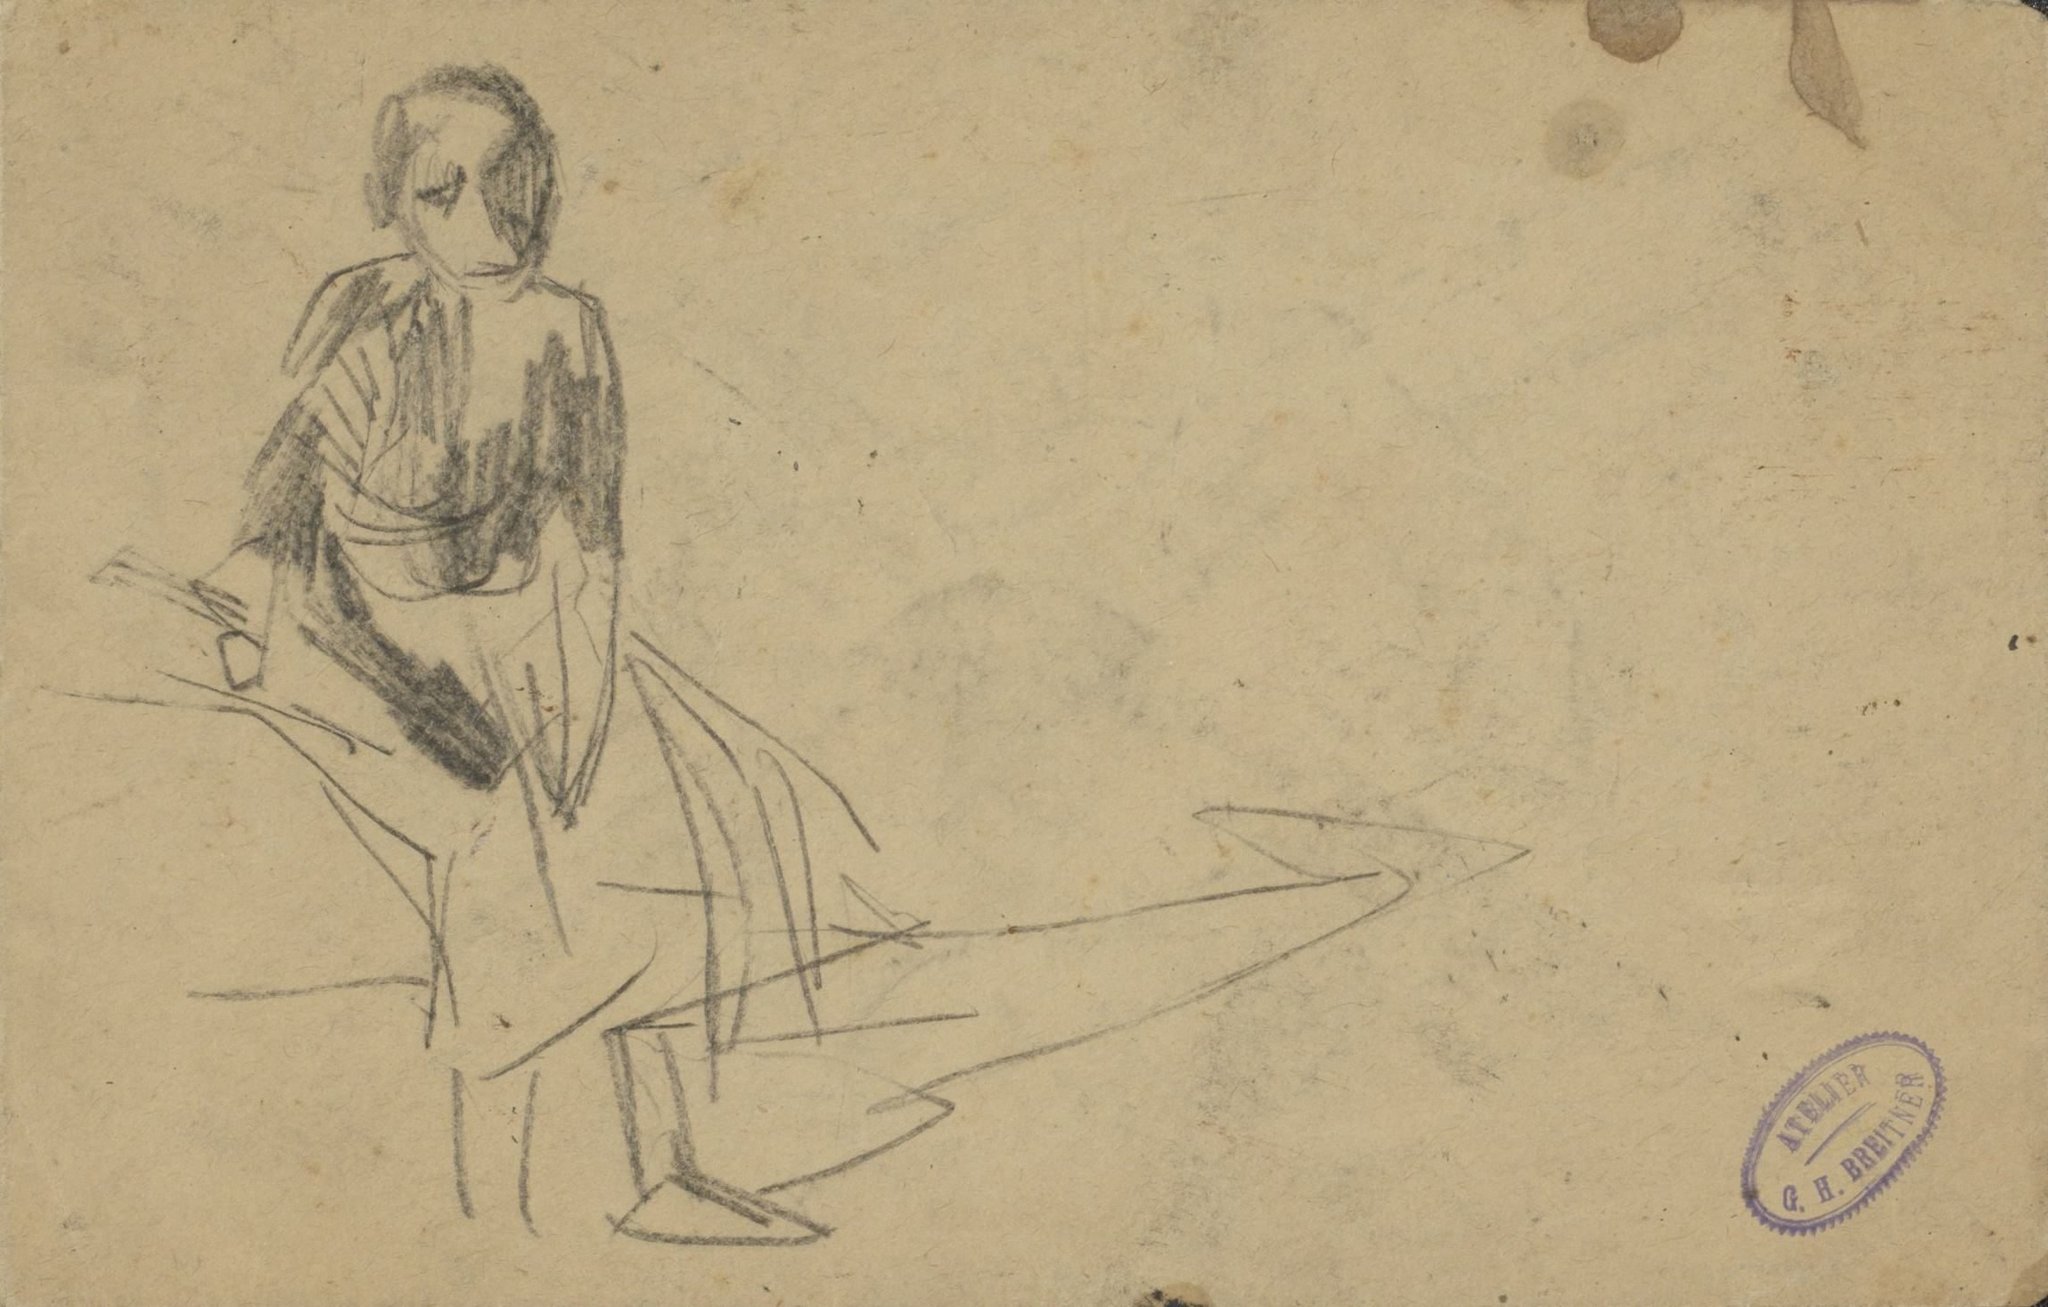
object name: envelope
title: Zittende vrouw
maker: george hendrik breitner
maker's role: draughtsman, painter, print maker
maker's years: 1857-1923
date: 1898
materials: chalk, paper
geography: amsterdam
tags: sitting on an elevation - aa - female human figure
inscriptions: workshop stamp: Lugt 291d